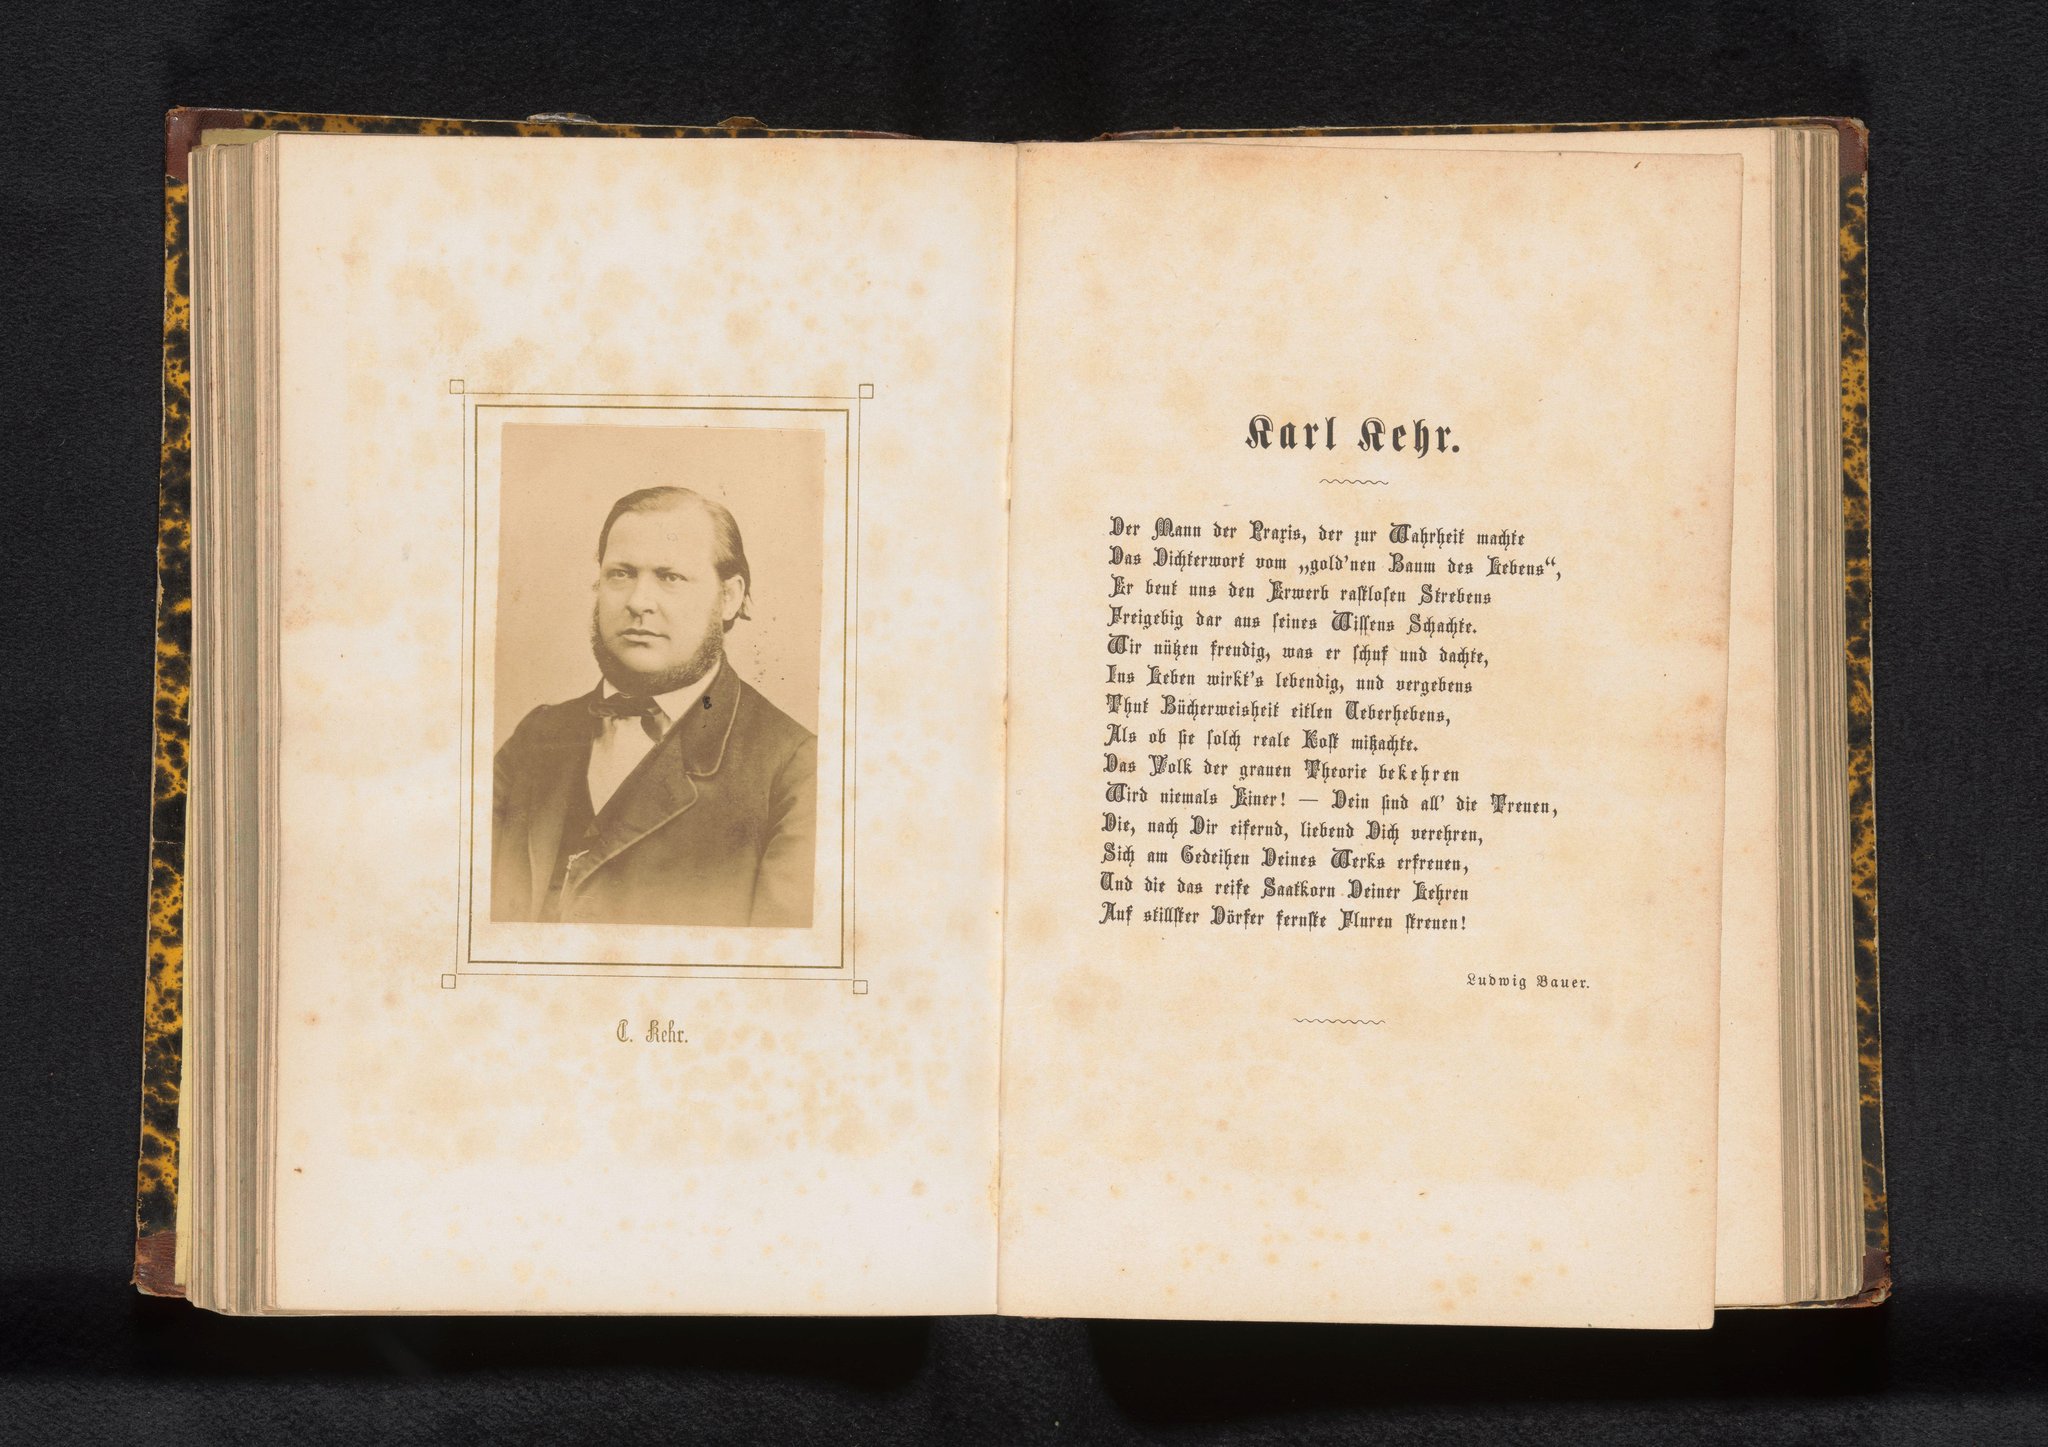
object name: photograph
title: Portret van Carl Kehr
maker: Anonymous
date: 1862-1872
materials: photographic support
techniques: albumen print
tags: adult man, portrait of a writer